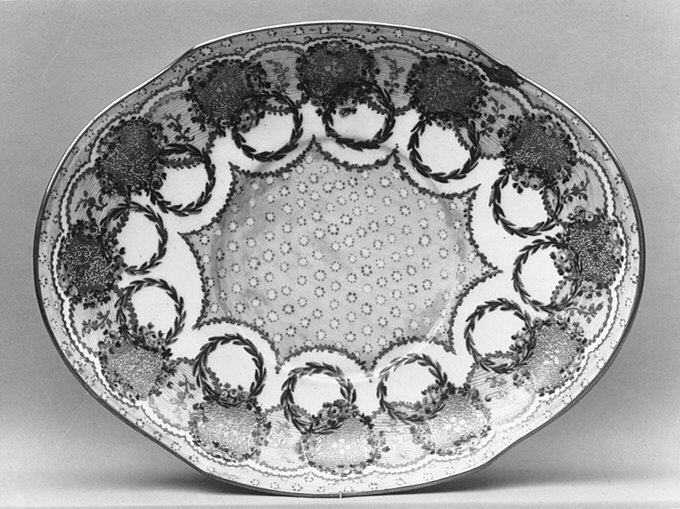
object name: tray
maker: sèvres manufactory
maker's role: manufactory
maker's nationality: french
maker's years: 1740-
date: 1768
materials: soft paste porcelain